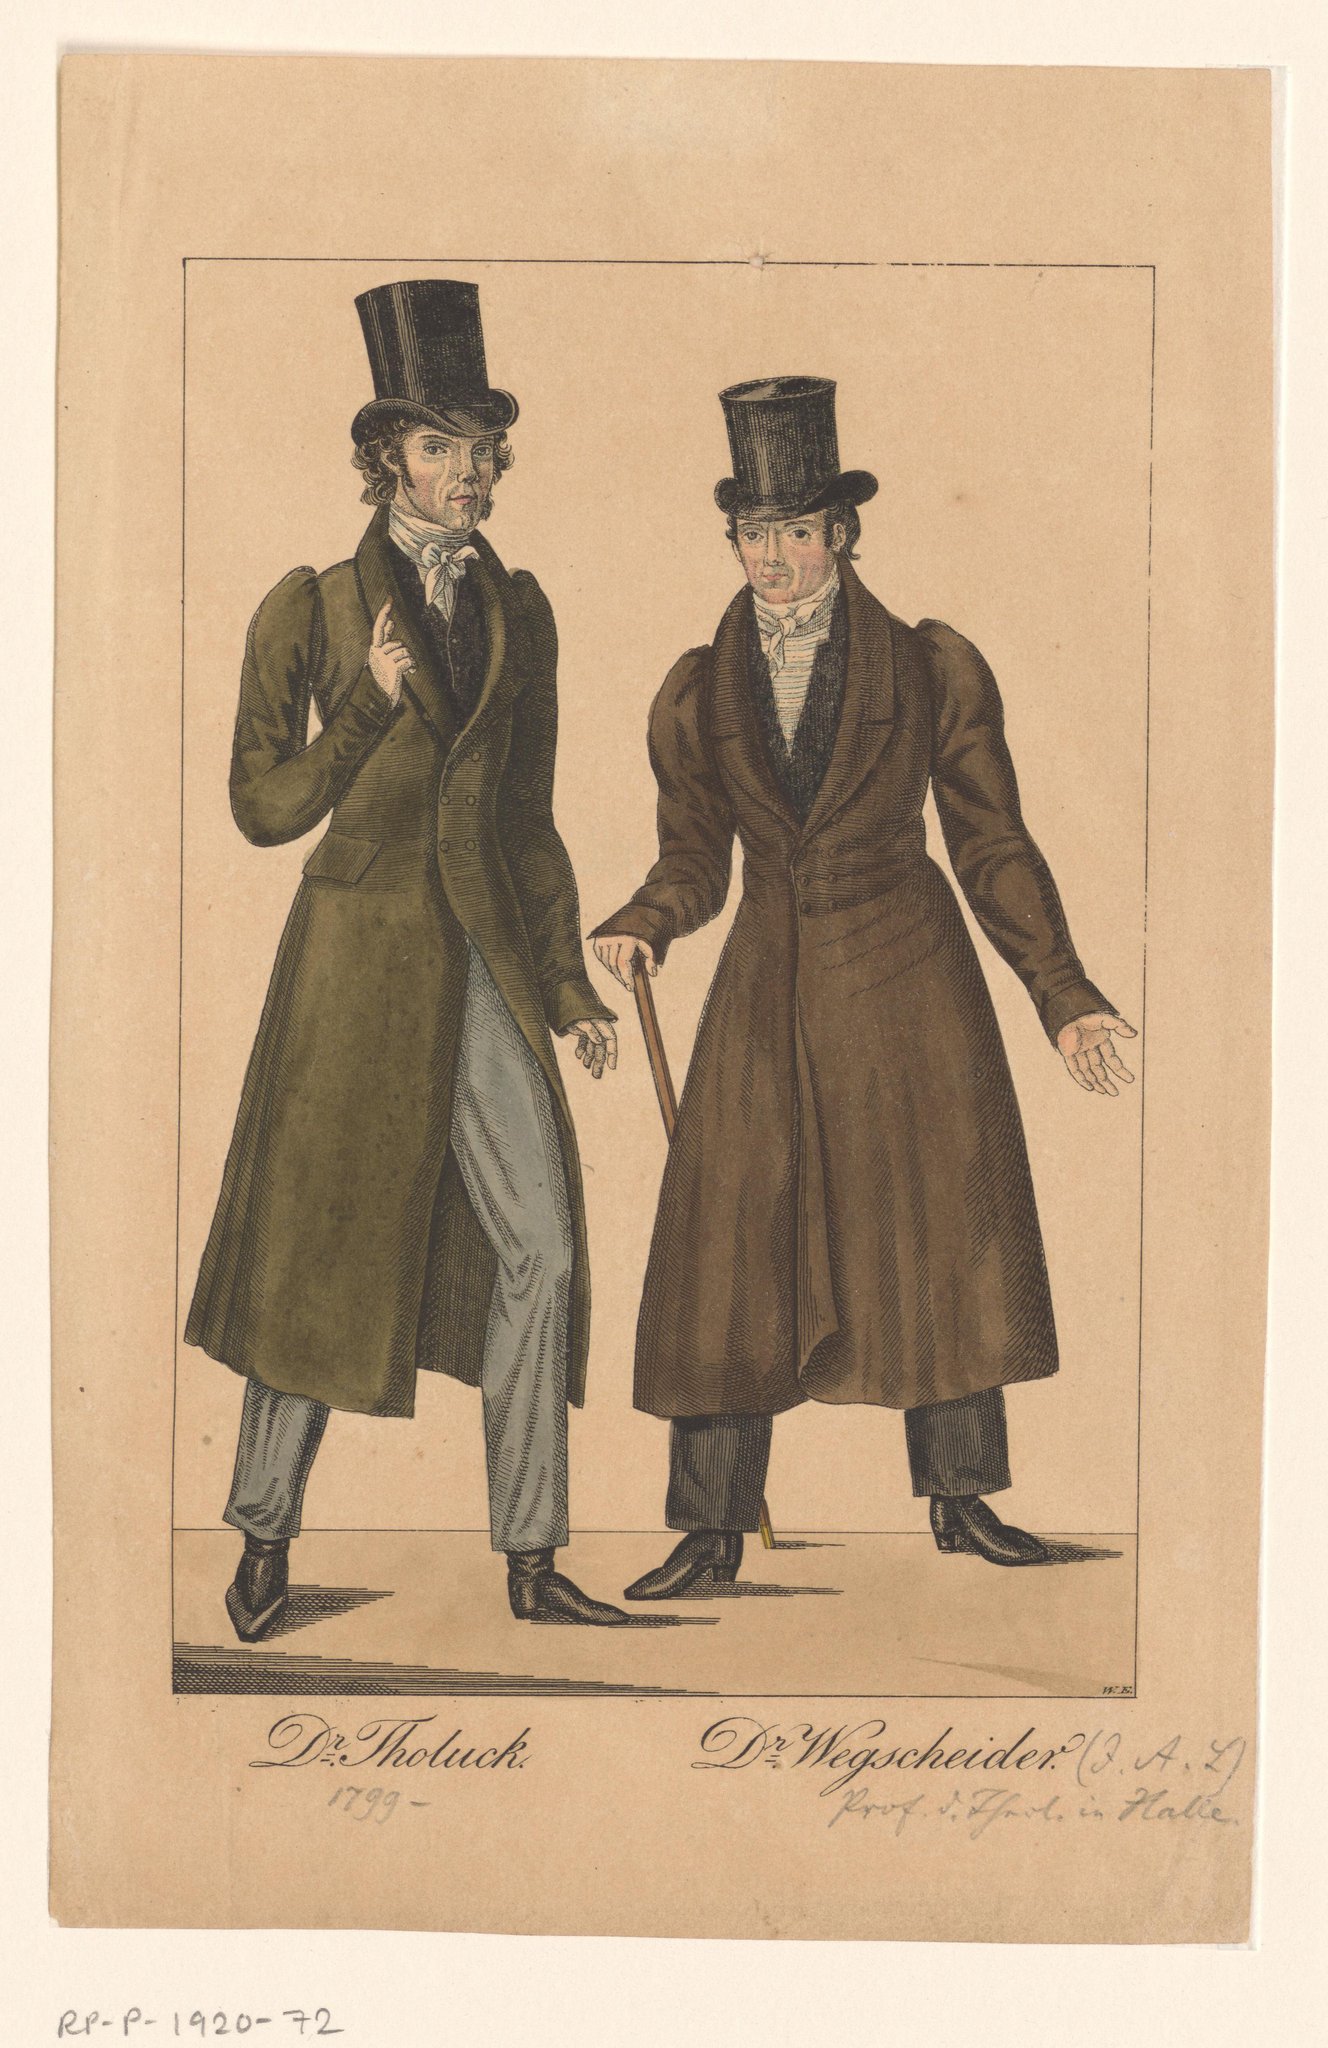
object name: print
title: Portret van August Tholuck en Julius August Ludwig Wegscheider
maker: Anonymous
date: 1825-1849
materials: paper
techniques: etching, hand coloring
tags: theologian, historical persons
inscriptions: collector's mark: Lugt 2228, initials: ‘W.E.’